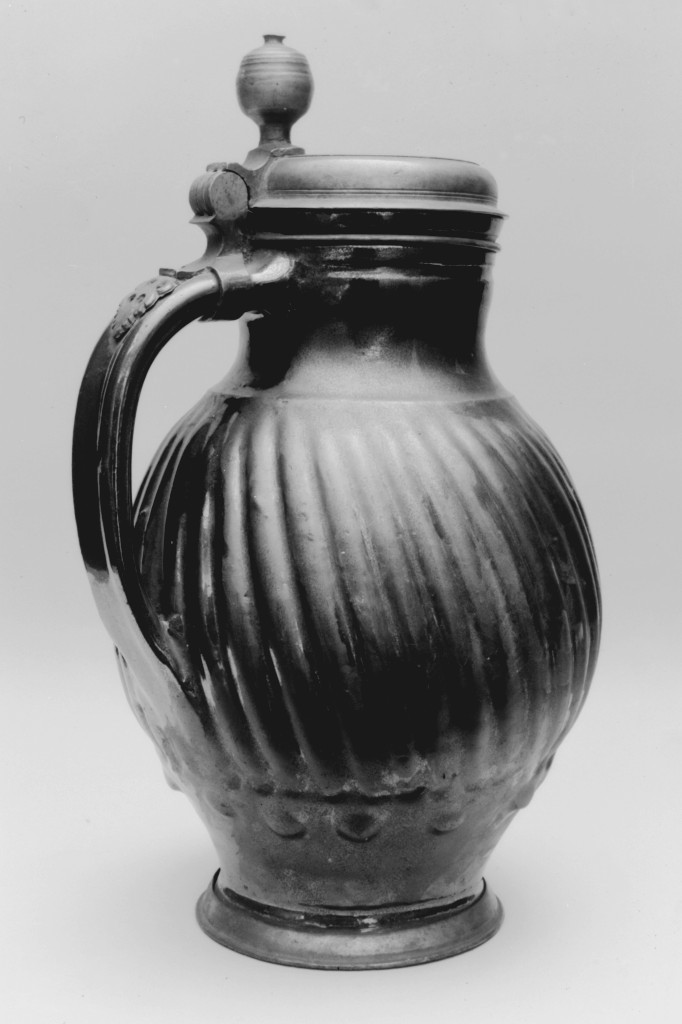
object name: tankard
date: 1701-1800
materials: pewter, stoneware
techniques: salt glaze